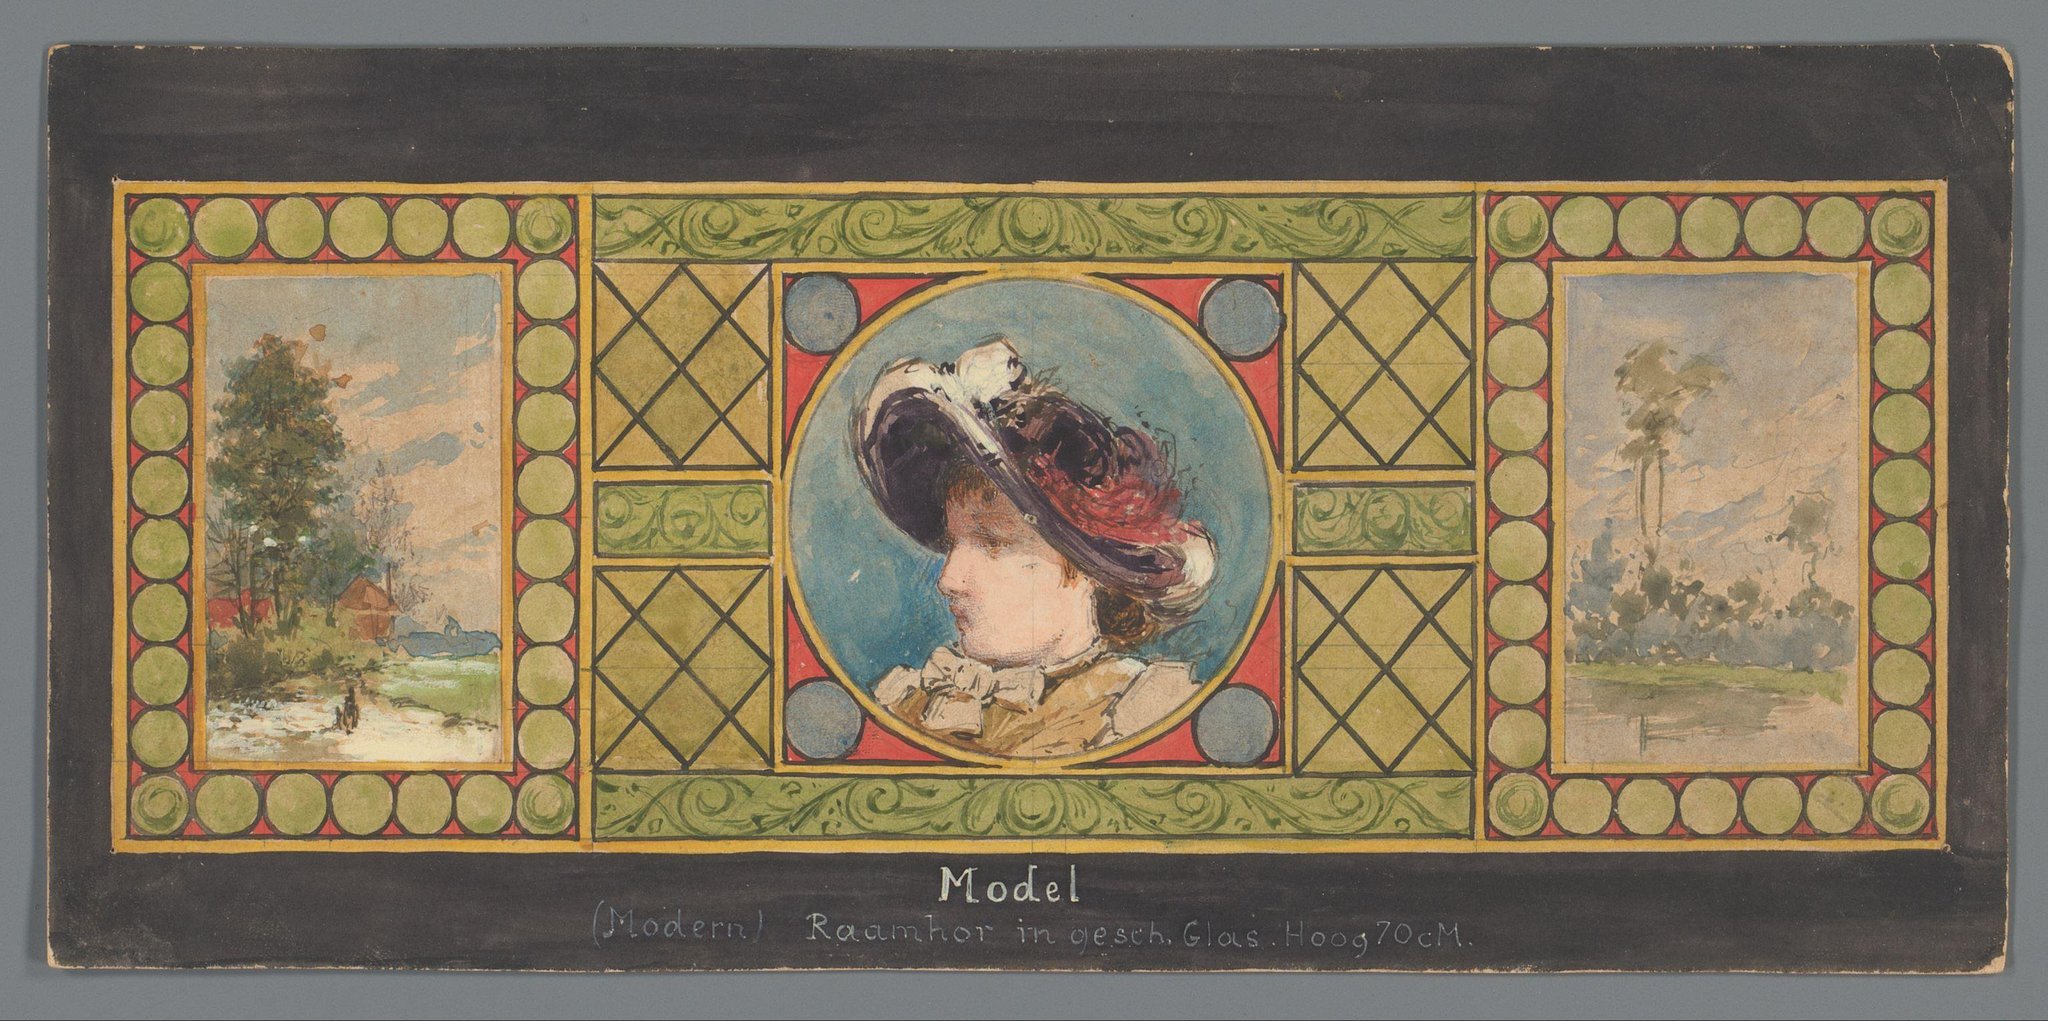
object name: drawing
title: Model (modern) raamhor in gesch. glas. Hoog 70 cm.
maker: Anonymous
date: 1850-1930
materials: paper, pencil, watercolor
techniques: brush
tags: landscapes in the temperate zone, anonymous historical person portrayed - bb - woman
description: Op de achterzijde twee potloodschetsen; de een van een soortgelijk drieluik, de ander van een mechanisch object.